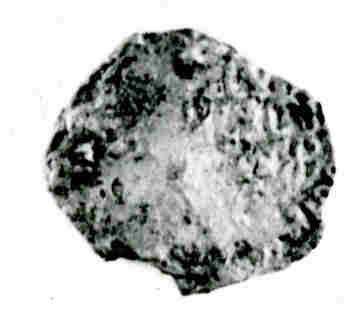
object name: coin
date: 758-768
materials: copper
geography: iran